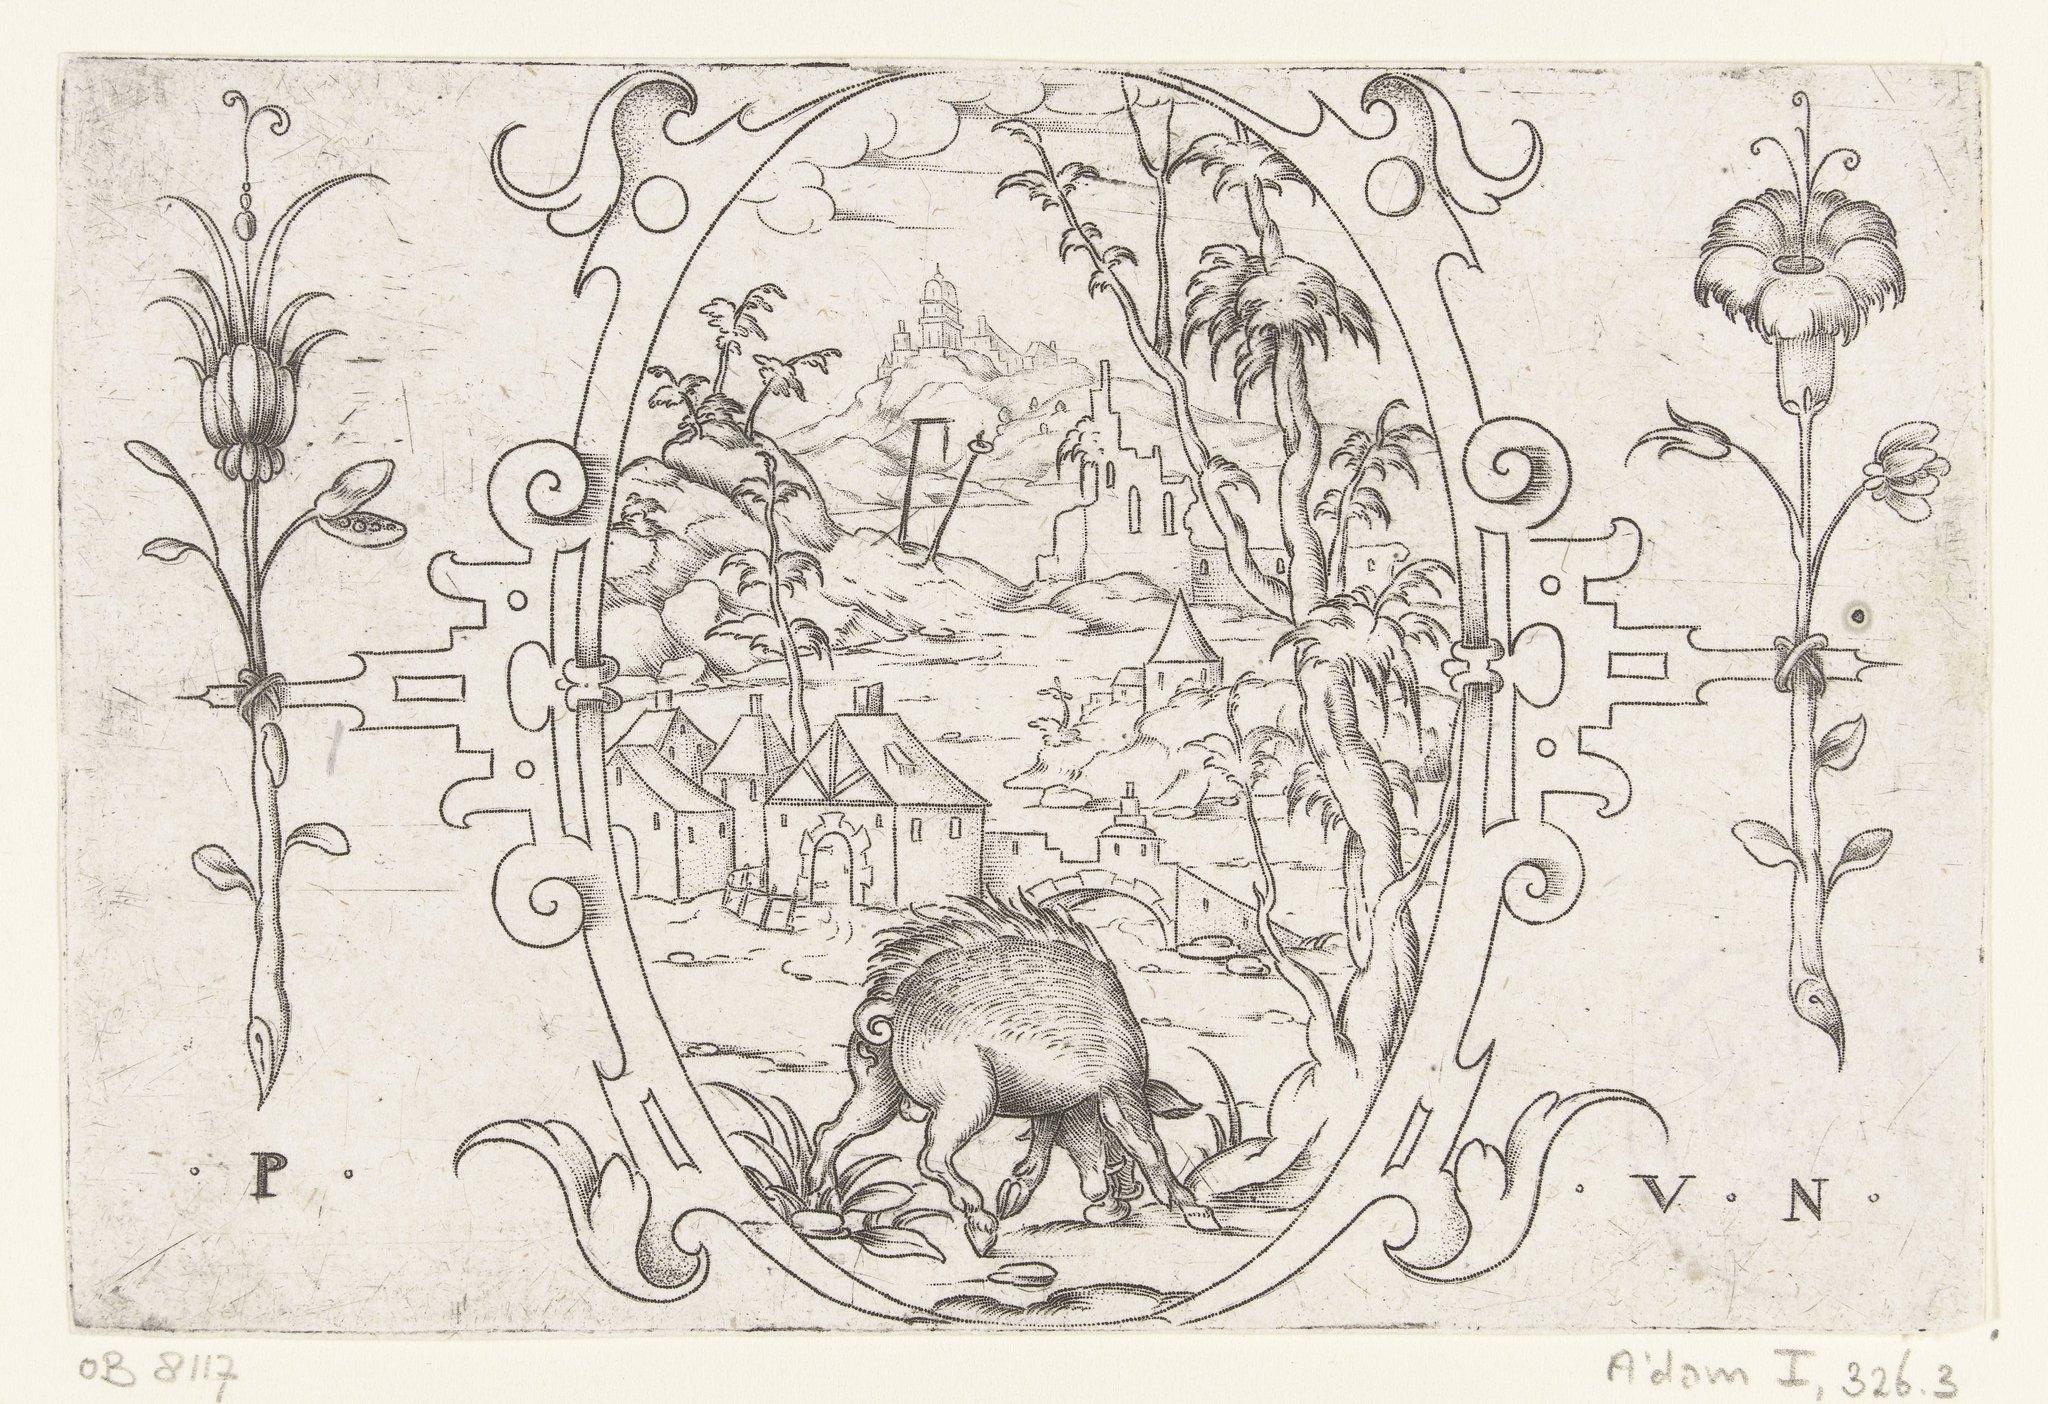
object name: print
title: Ovaal met een everzwijn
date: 1600-1699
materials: paper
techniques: engraving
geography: germany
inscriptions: collector's mark: Lugt 240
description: Aan het ovaal hangt aan weerszijden een bloem. Uit serie van 12 bladen.